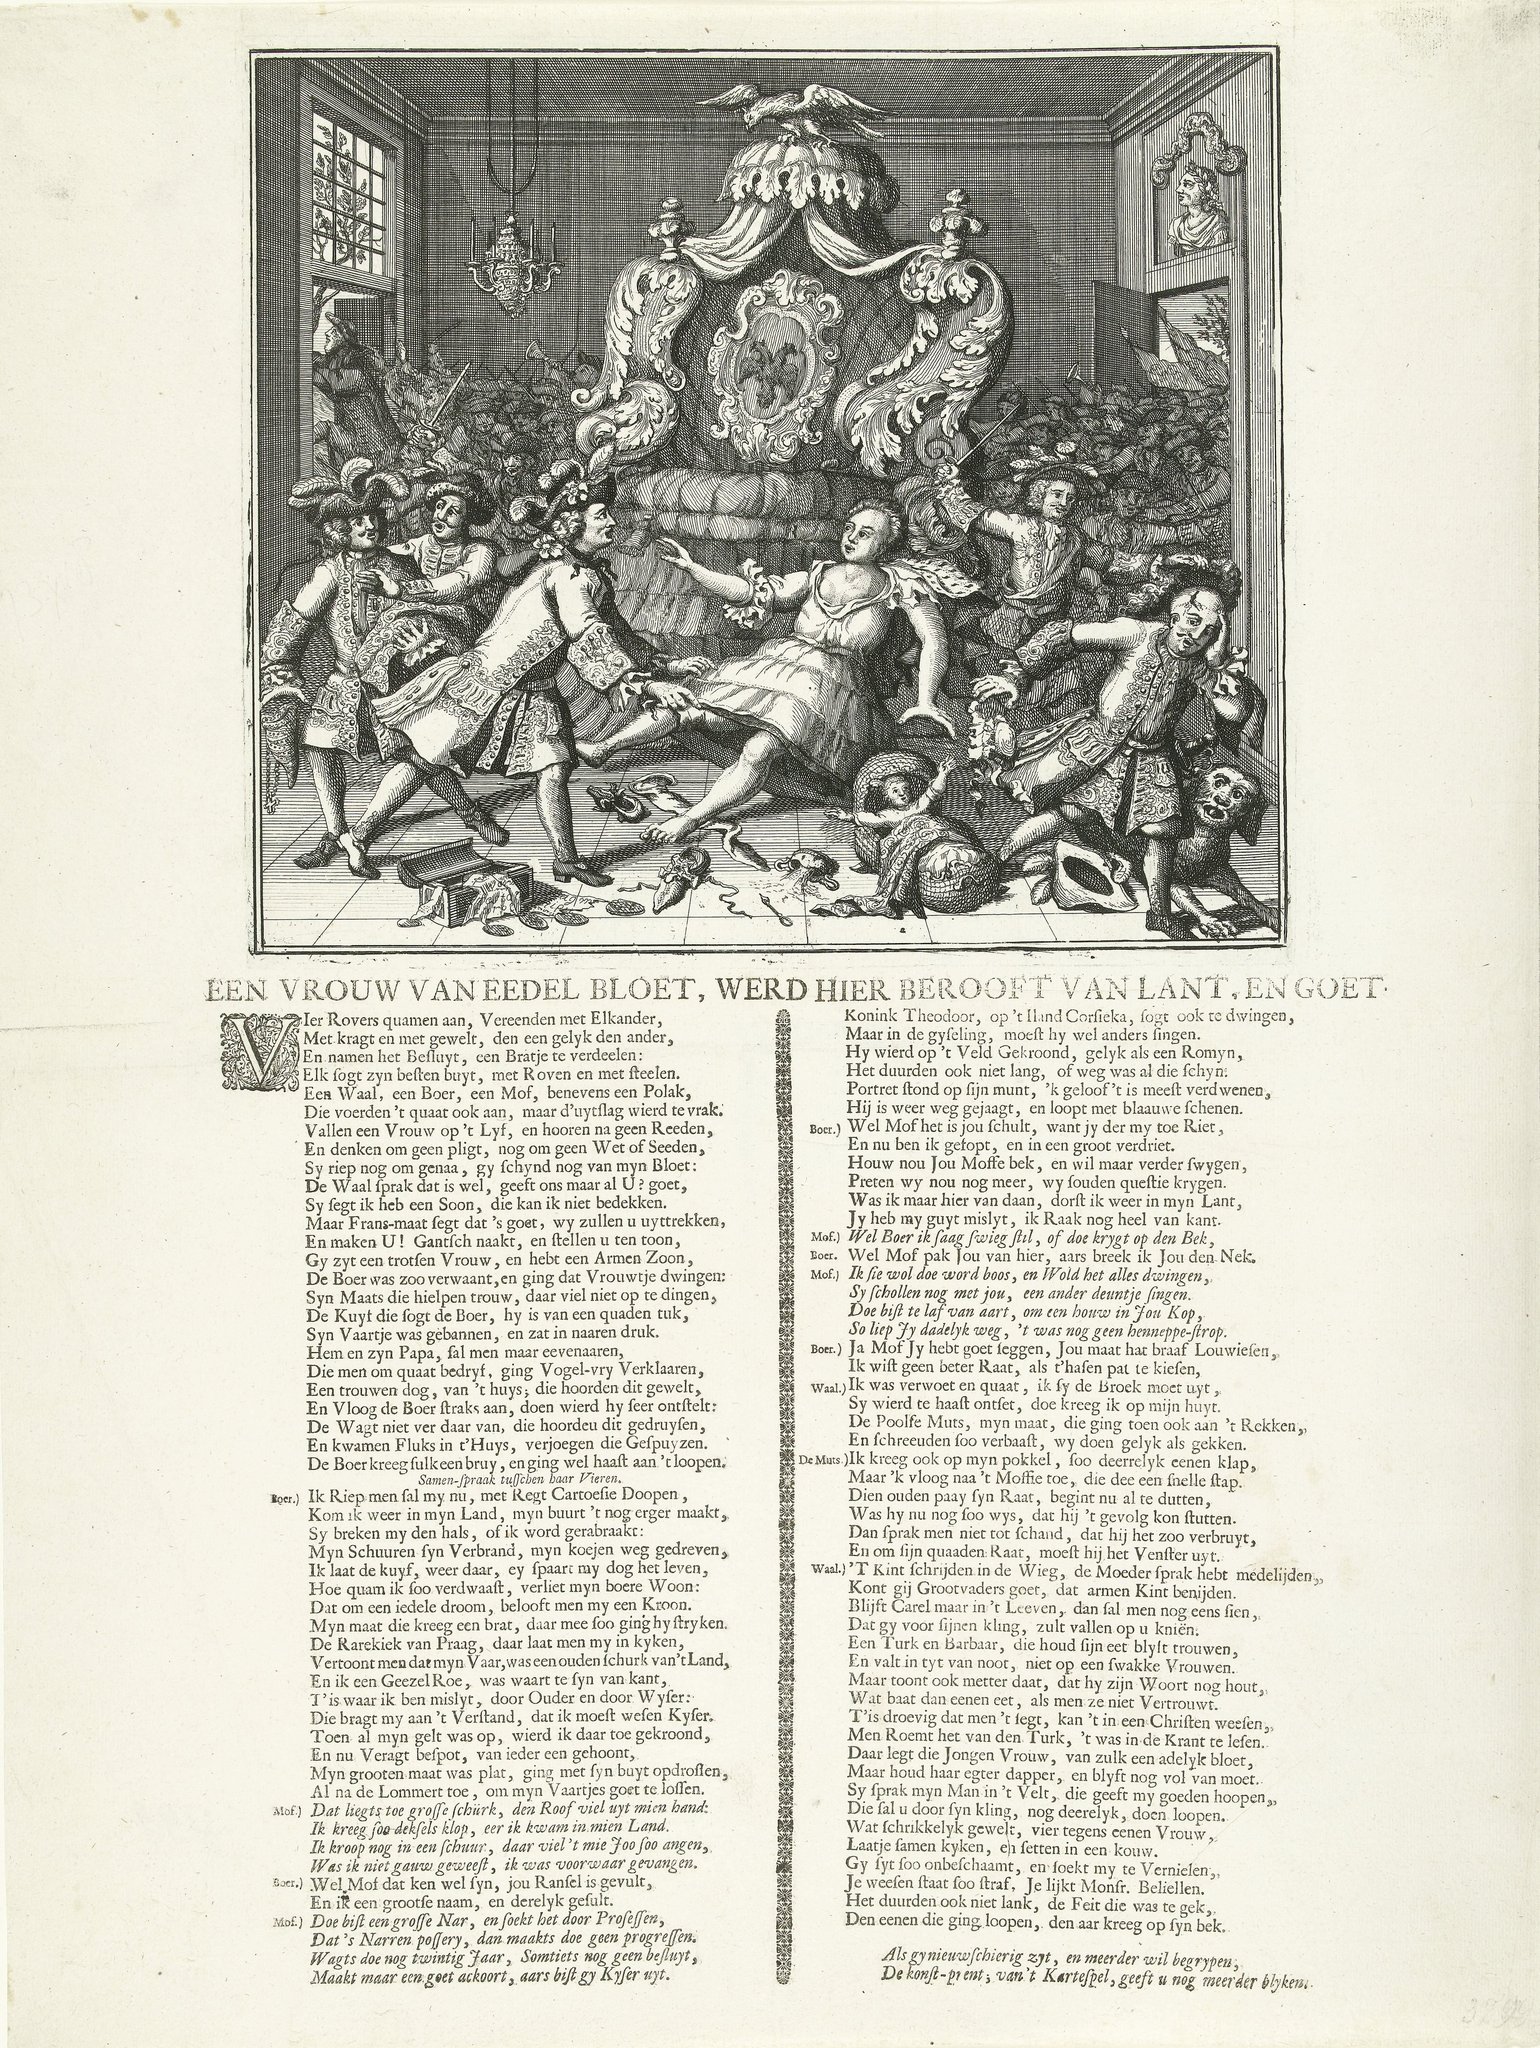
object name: cartoon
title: Spotprent op de mislukte poging om de Oostenrijkse landen te roven, 1742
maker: Anonymous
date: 1742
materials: paper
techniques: etching, letterpress printing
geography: northern netherlands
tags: vienna, ludwig andreas von khevenhüller, maria theresia (rooms-duits keizerin), political caricatures and satires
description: Spotprent op de mislukte pogingen om de Oostenrijkse landen te roven, 1742. Frankrijk, Beieren, Pruisen en Polen dringen de slaapkamer van aartshertogin Maria Theresia van Oostenrijk binnen om haar kleding en juwelen te roven. Op de grond ligt het kind Jozef in de wieg. Rechts komen echter de Hongaarse troepen onder maarschalk Khevenhüller binnen om de indringers te verdrijven. Allegorie op de Oostenrijkse successieoorlog. Op het blad onder de plaat een vers in twee kolommen.